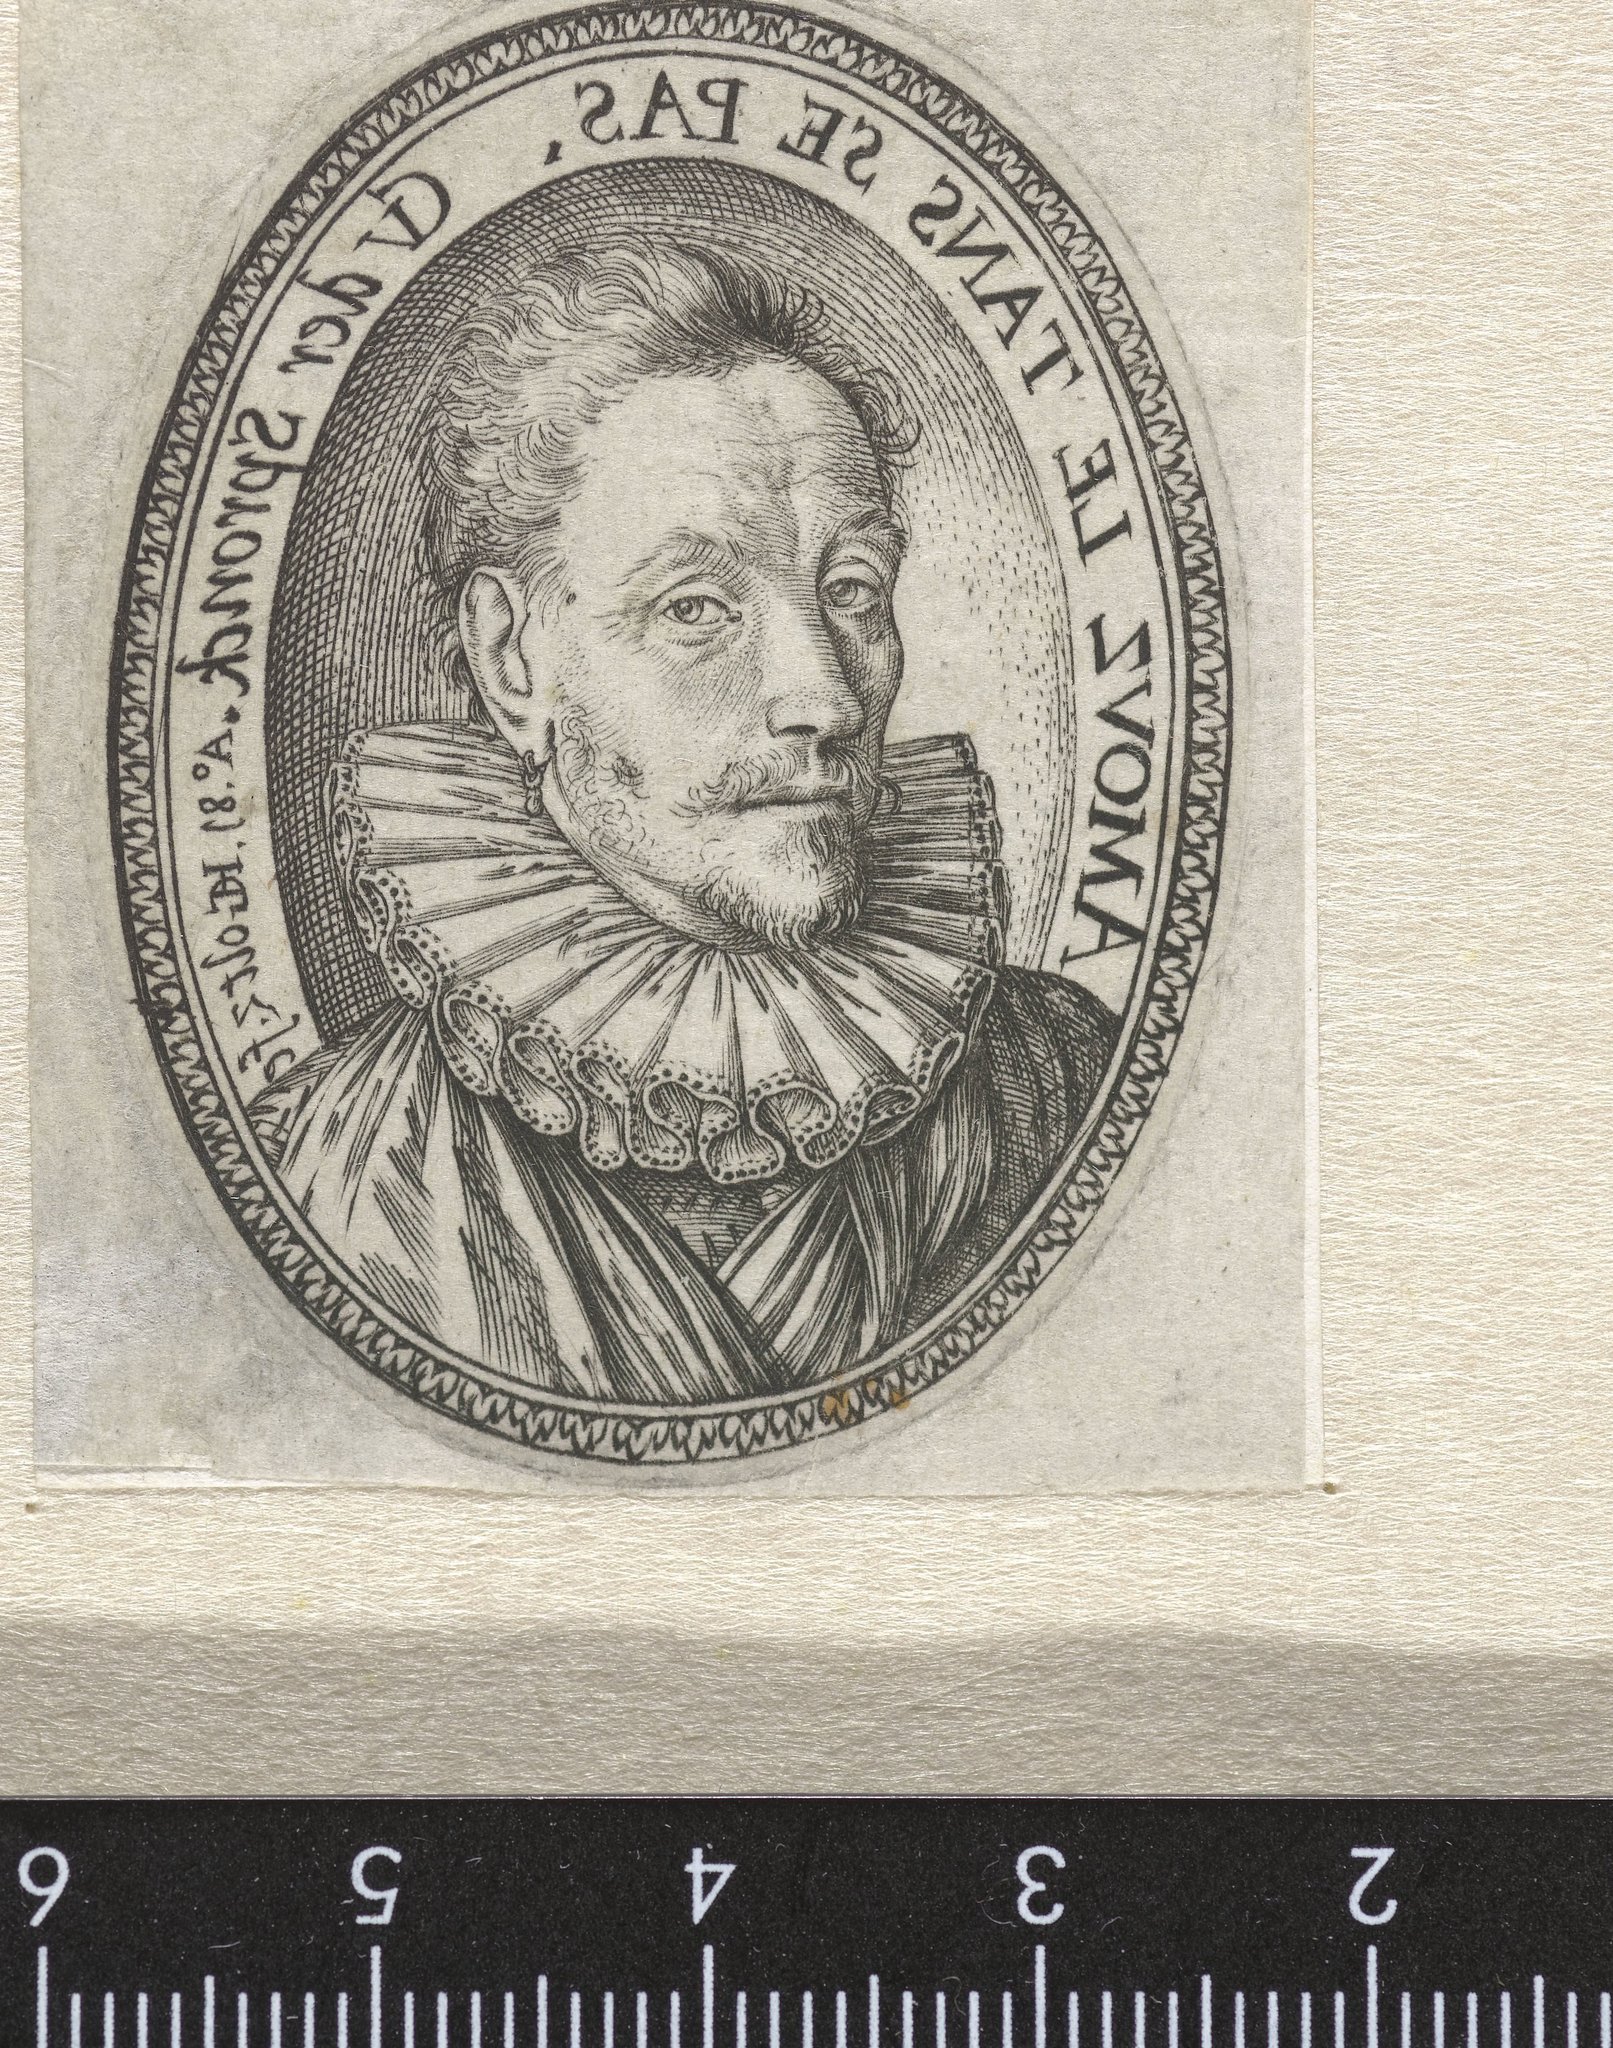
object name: print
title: Portret van Geeraert Verspronck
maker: hendrick goltzius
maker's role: draughtsman, painter, print maker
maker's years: 1558-1617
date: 1581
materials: paper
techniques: engraving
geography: haarlem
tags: portrait, self-portrait of artist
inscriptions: collector's mark: Lugt 2228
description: Portretbuste van Geeraert Verspronck, in ovaal met randschrift in spiegelbeeld.